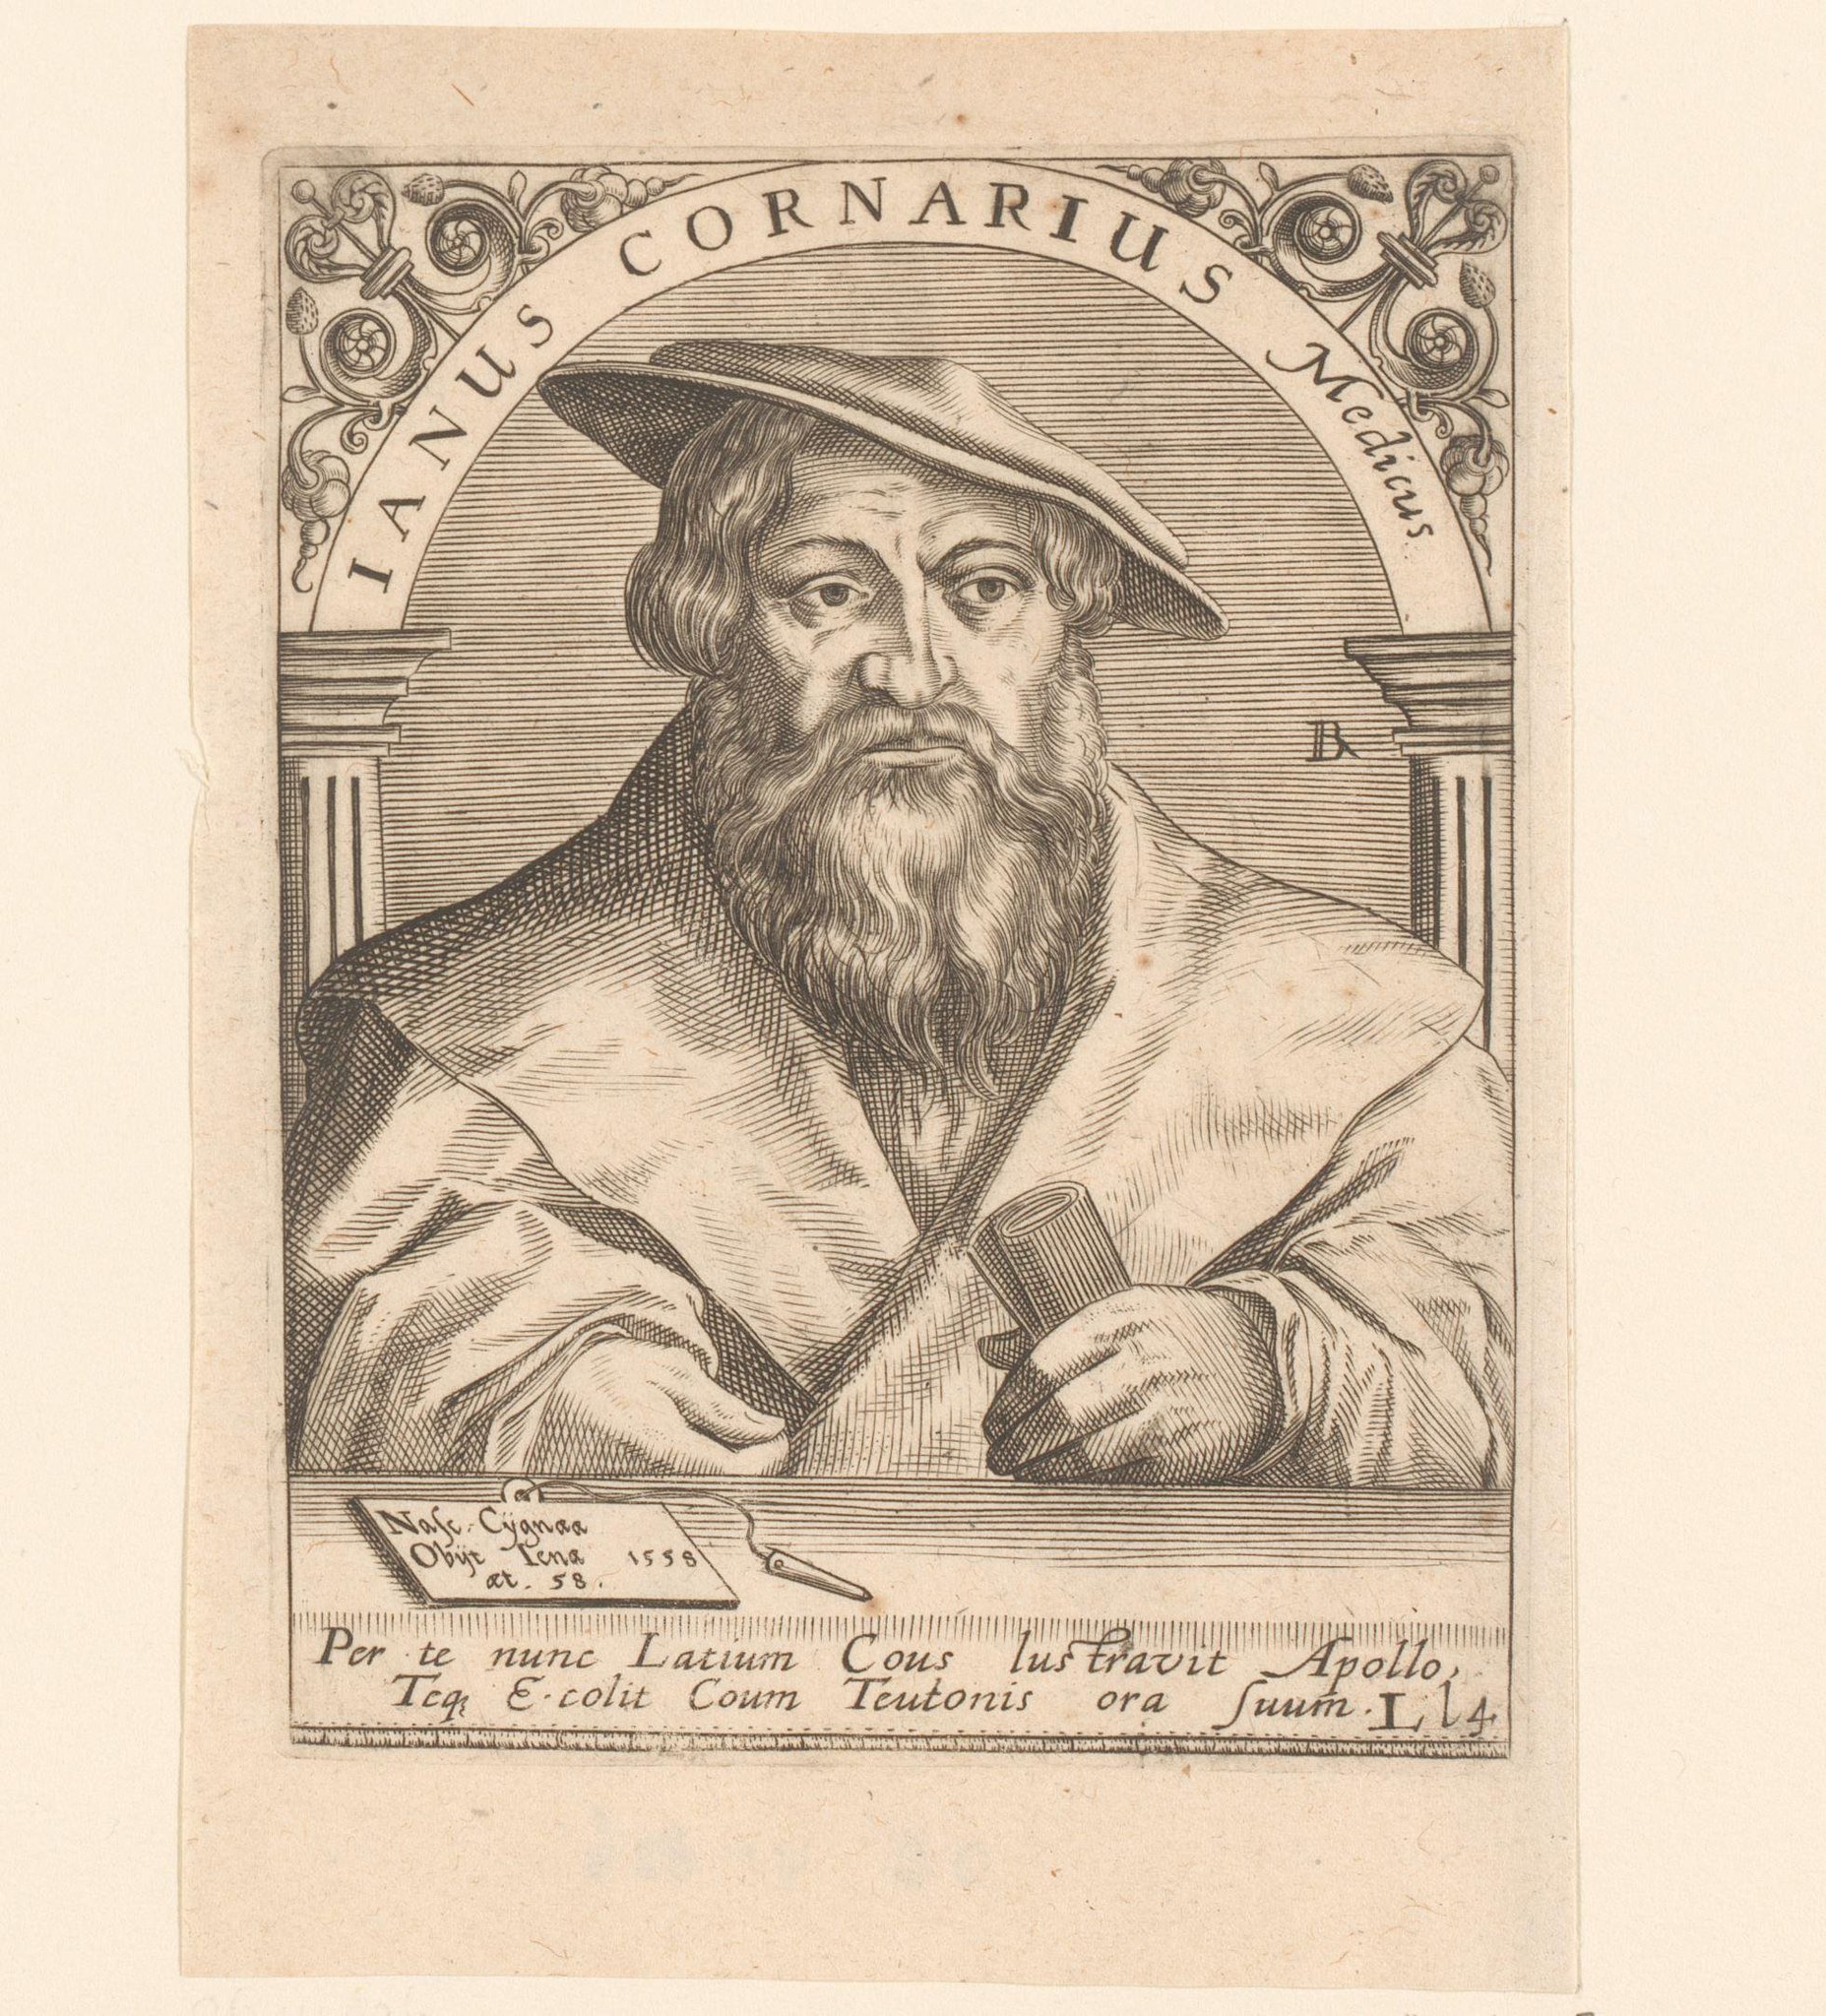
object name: print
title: Serie portretten van vijftiende- en zestiende-eeuwse geleerden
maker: robert boissard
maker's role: print maker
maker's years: 1570-1611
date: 1597-1599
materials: paper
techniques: engraving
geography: france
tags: historical persons